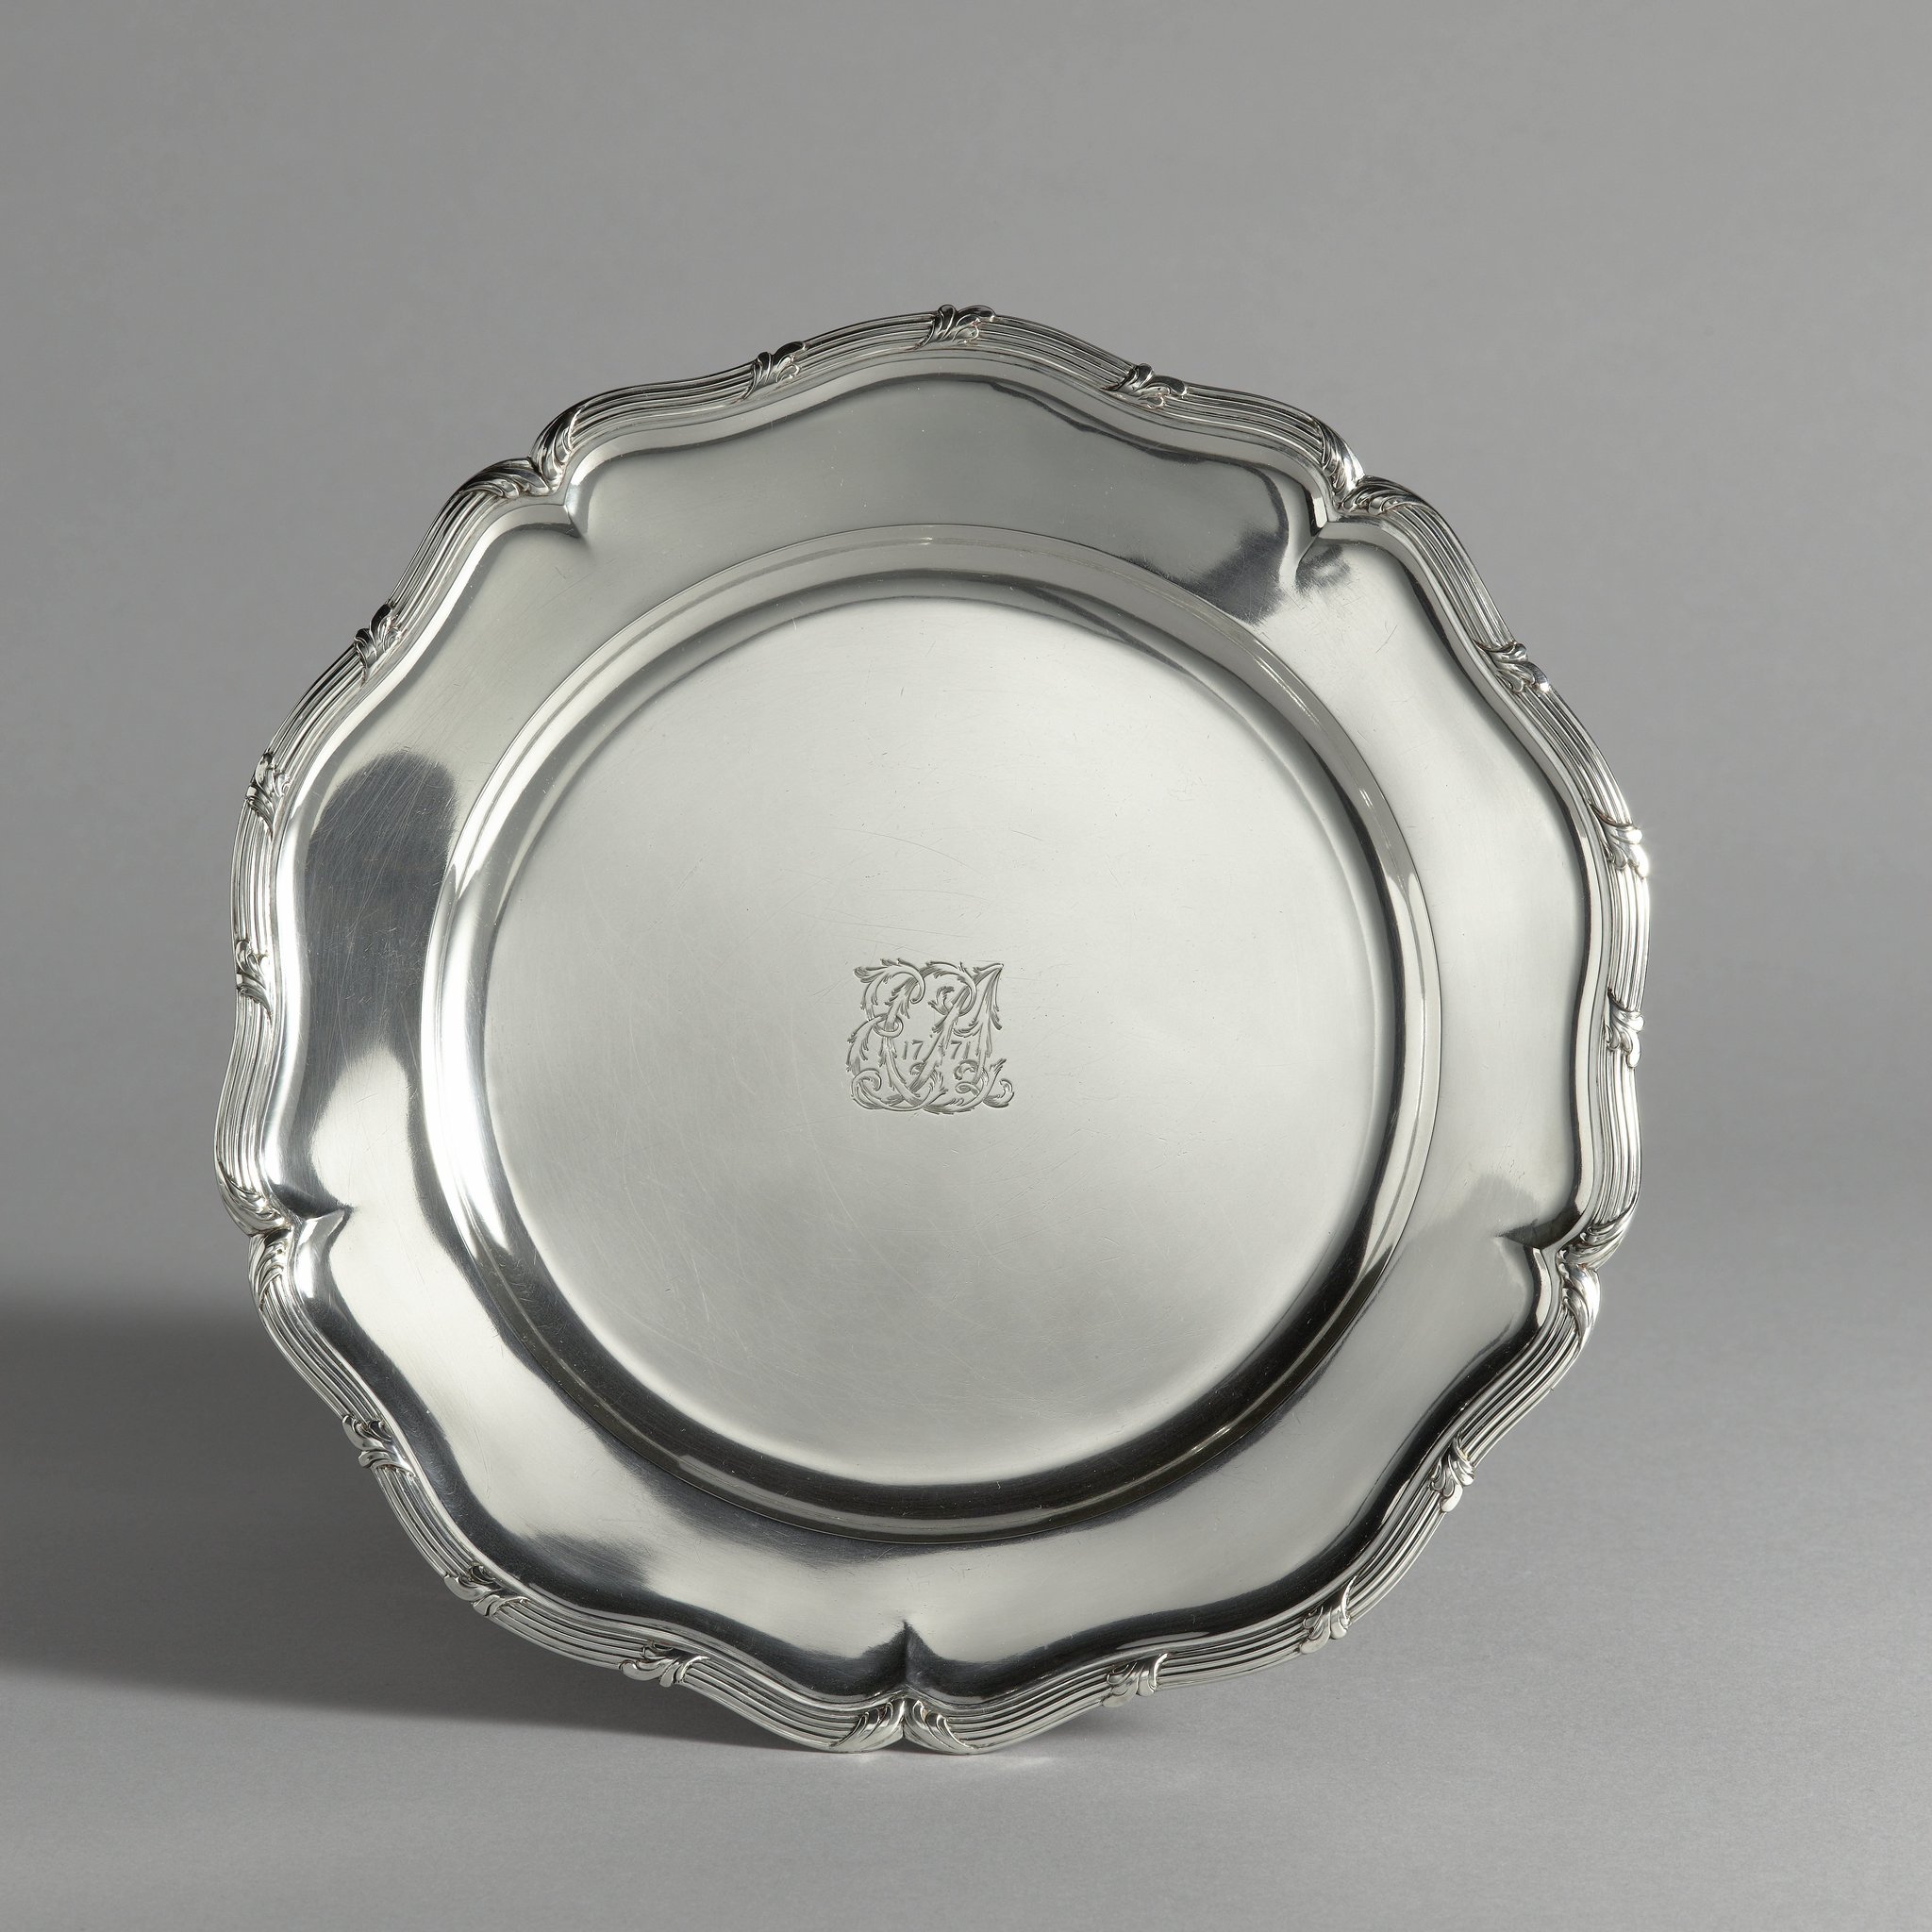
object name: avondmaalsschotel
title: Avondmaalsschotel voor The Englisch Reformed Church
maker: johannes schiotling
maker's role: silversmith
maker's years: 1730-1799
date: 1771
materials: silver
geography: amsterdam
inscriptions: alloy mark: ‘Hollandse leeuw’, maker's mark, town mark: ‘Amsterdam’, date letter: ‘M (=1771)’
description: Baptismal font, one large and two small bread dishes and two ebony offertory boxes, made for the English Reformed Church in Amsterdam, largely at the expense of the banker John Hope. Silver and ebony. Amsterdam, 1771, by Johannes Schiotling. On loan from the English Reformed Church, Amsterdam.